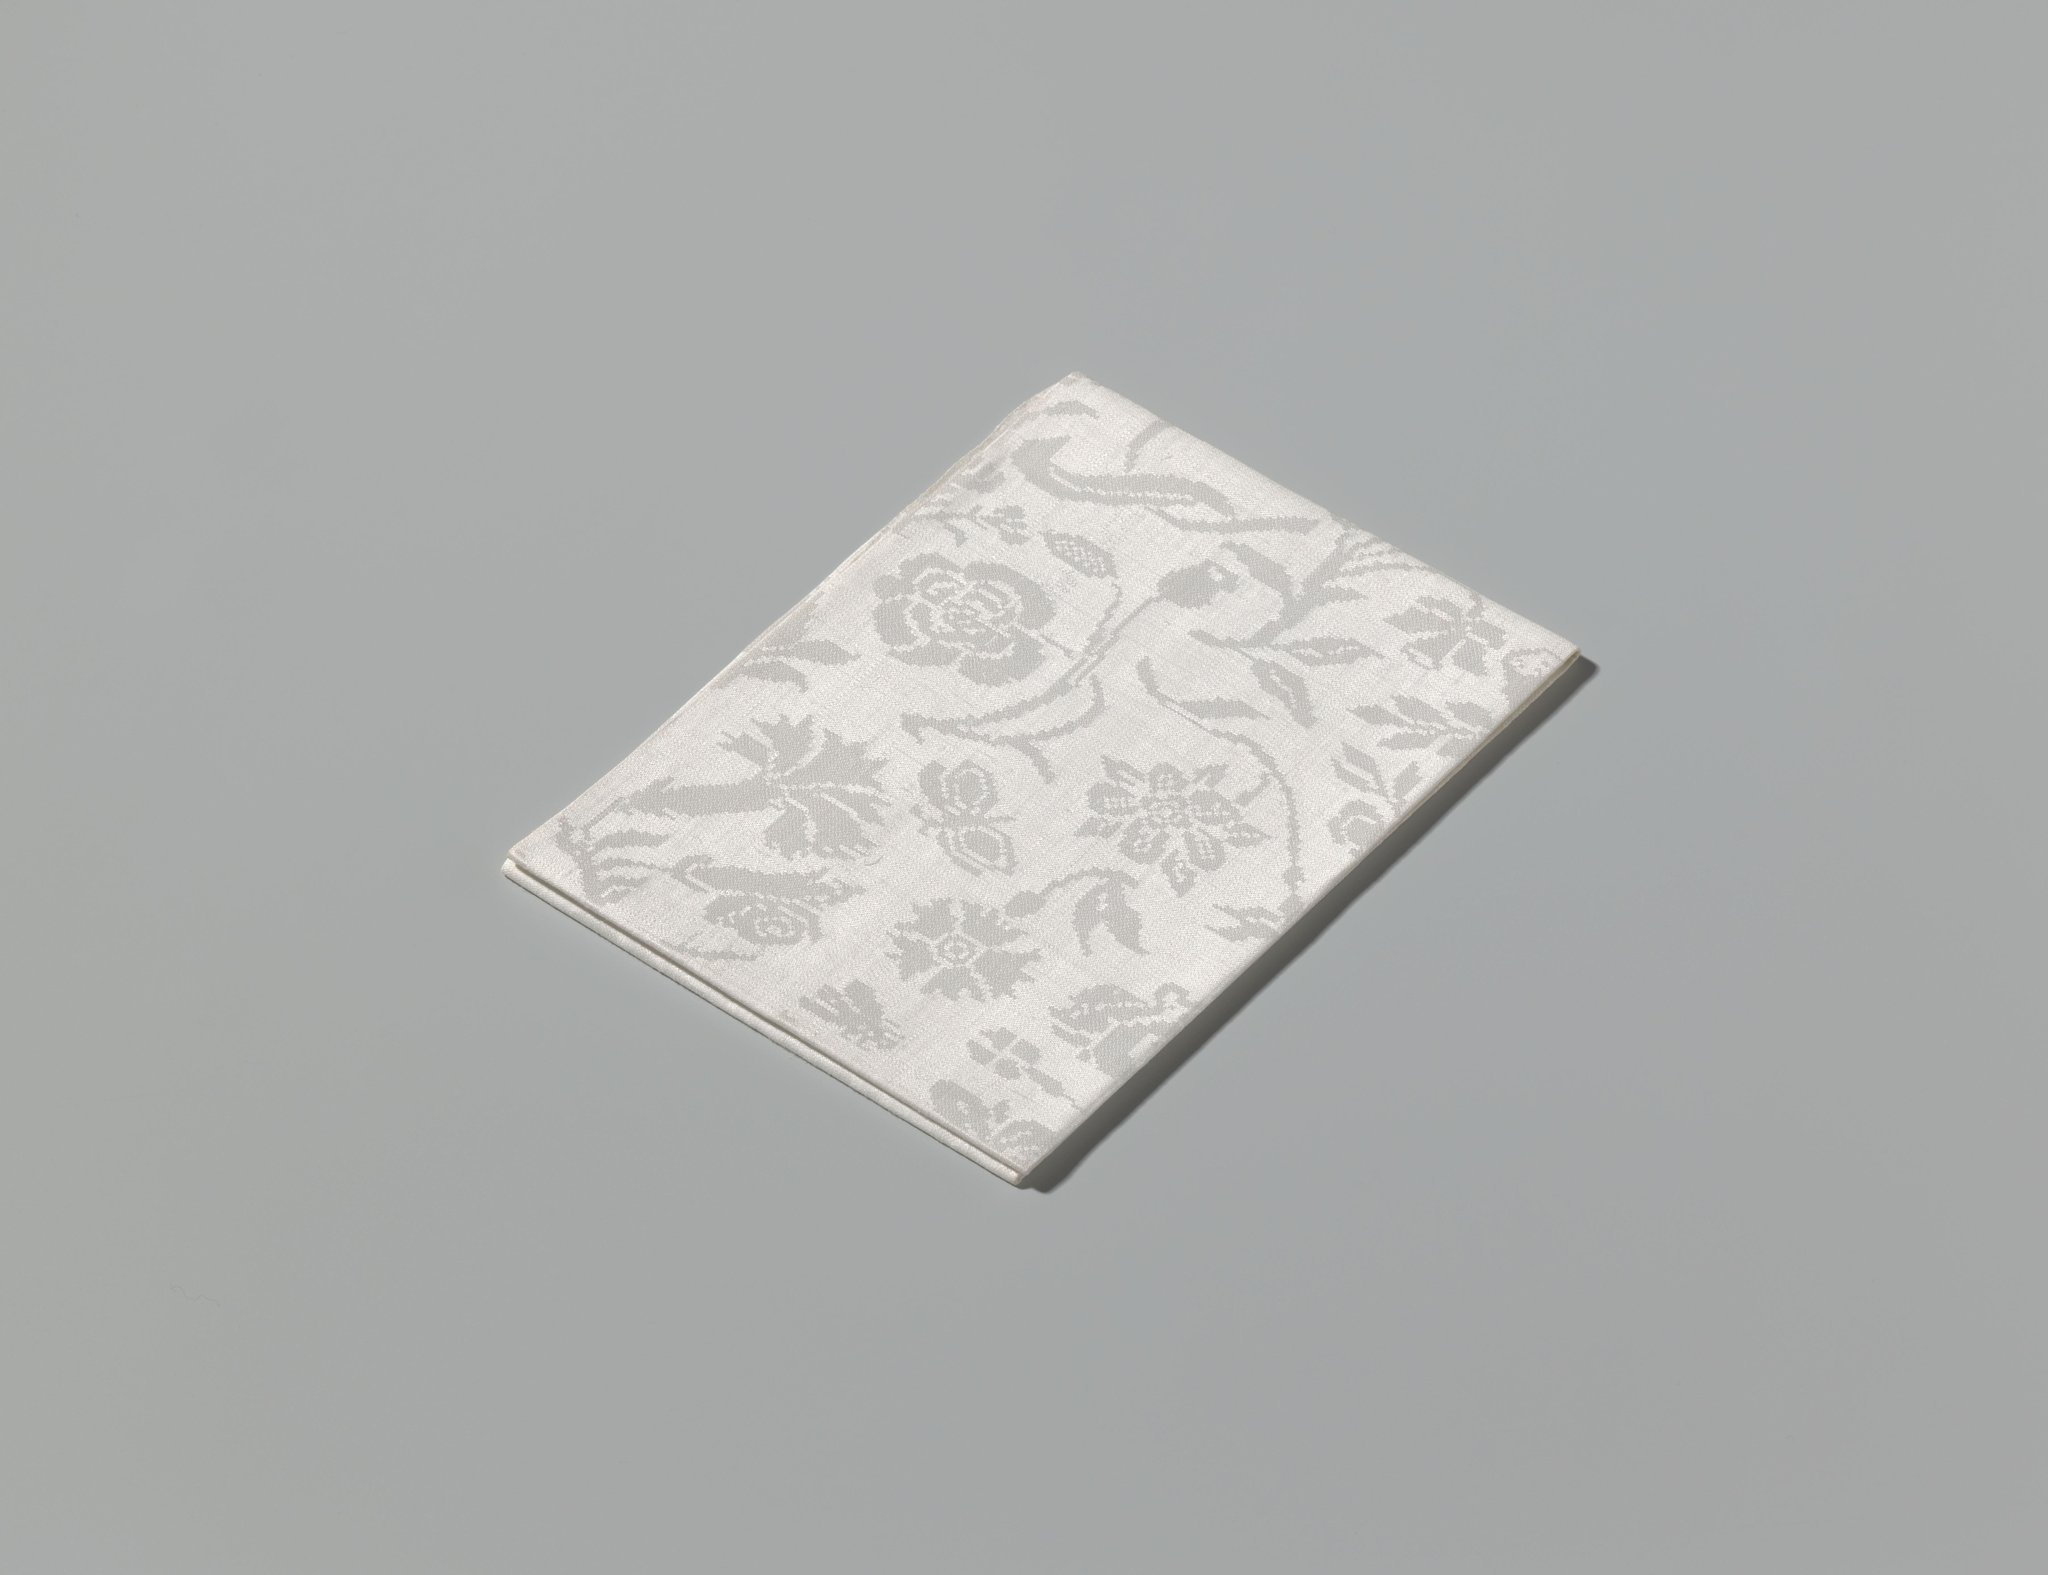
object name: napkin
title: Servet van wit linnendamast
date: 1640-1650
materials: linen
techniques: damask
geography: northern netherlands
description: Wit linnendamasten servet met patroon van gestrooide bloemen en insecten, merk kroon IB 24.